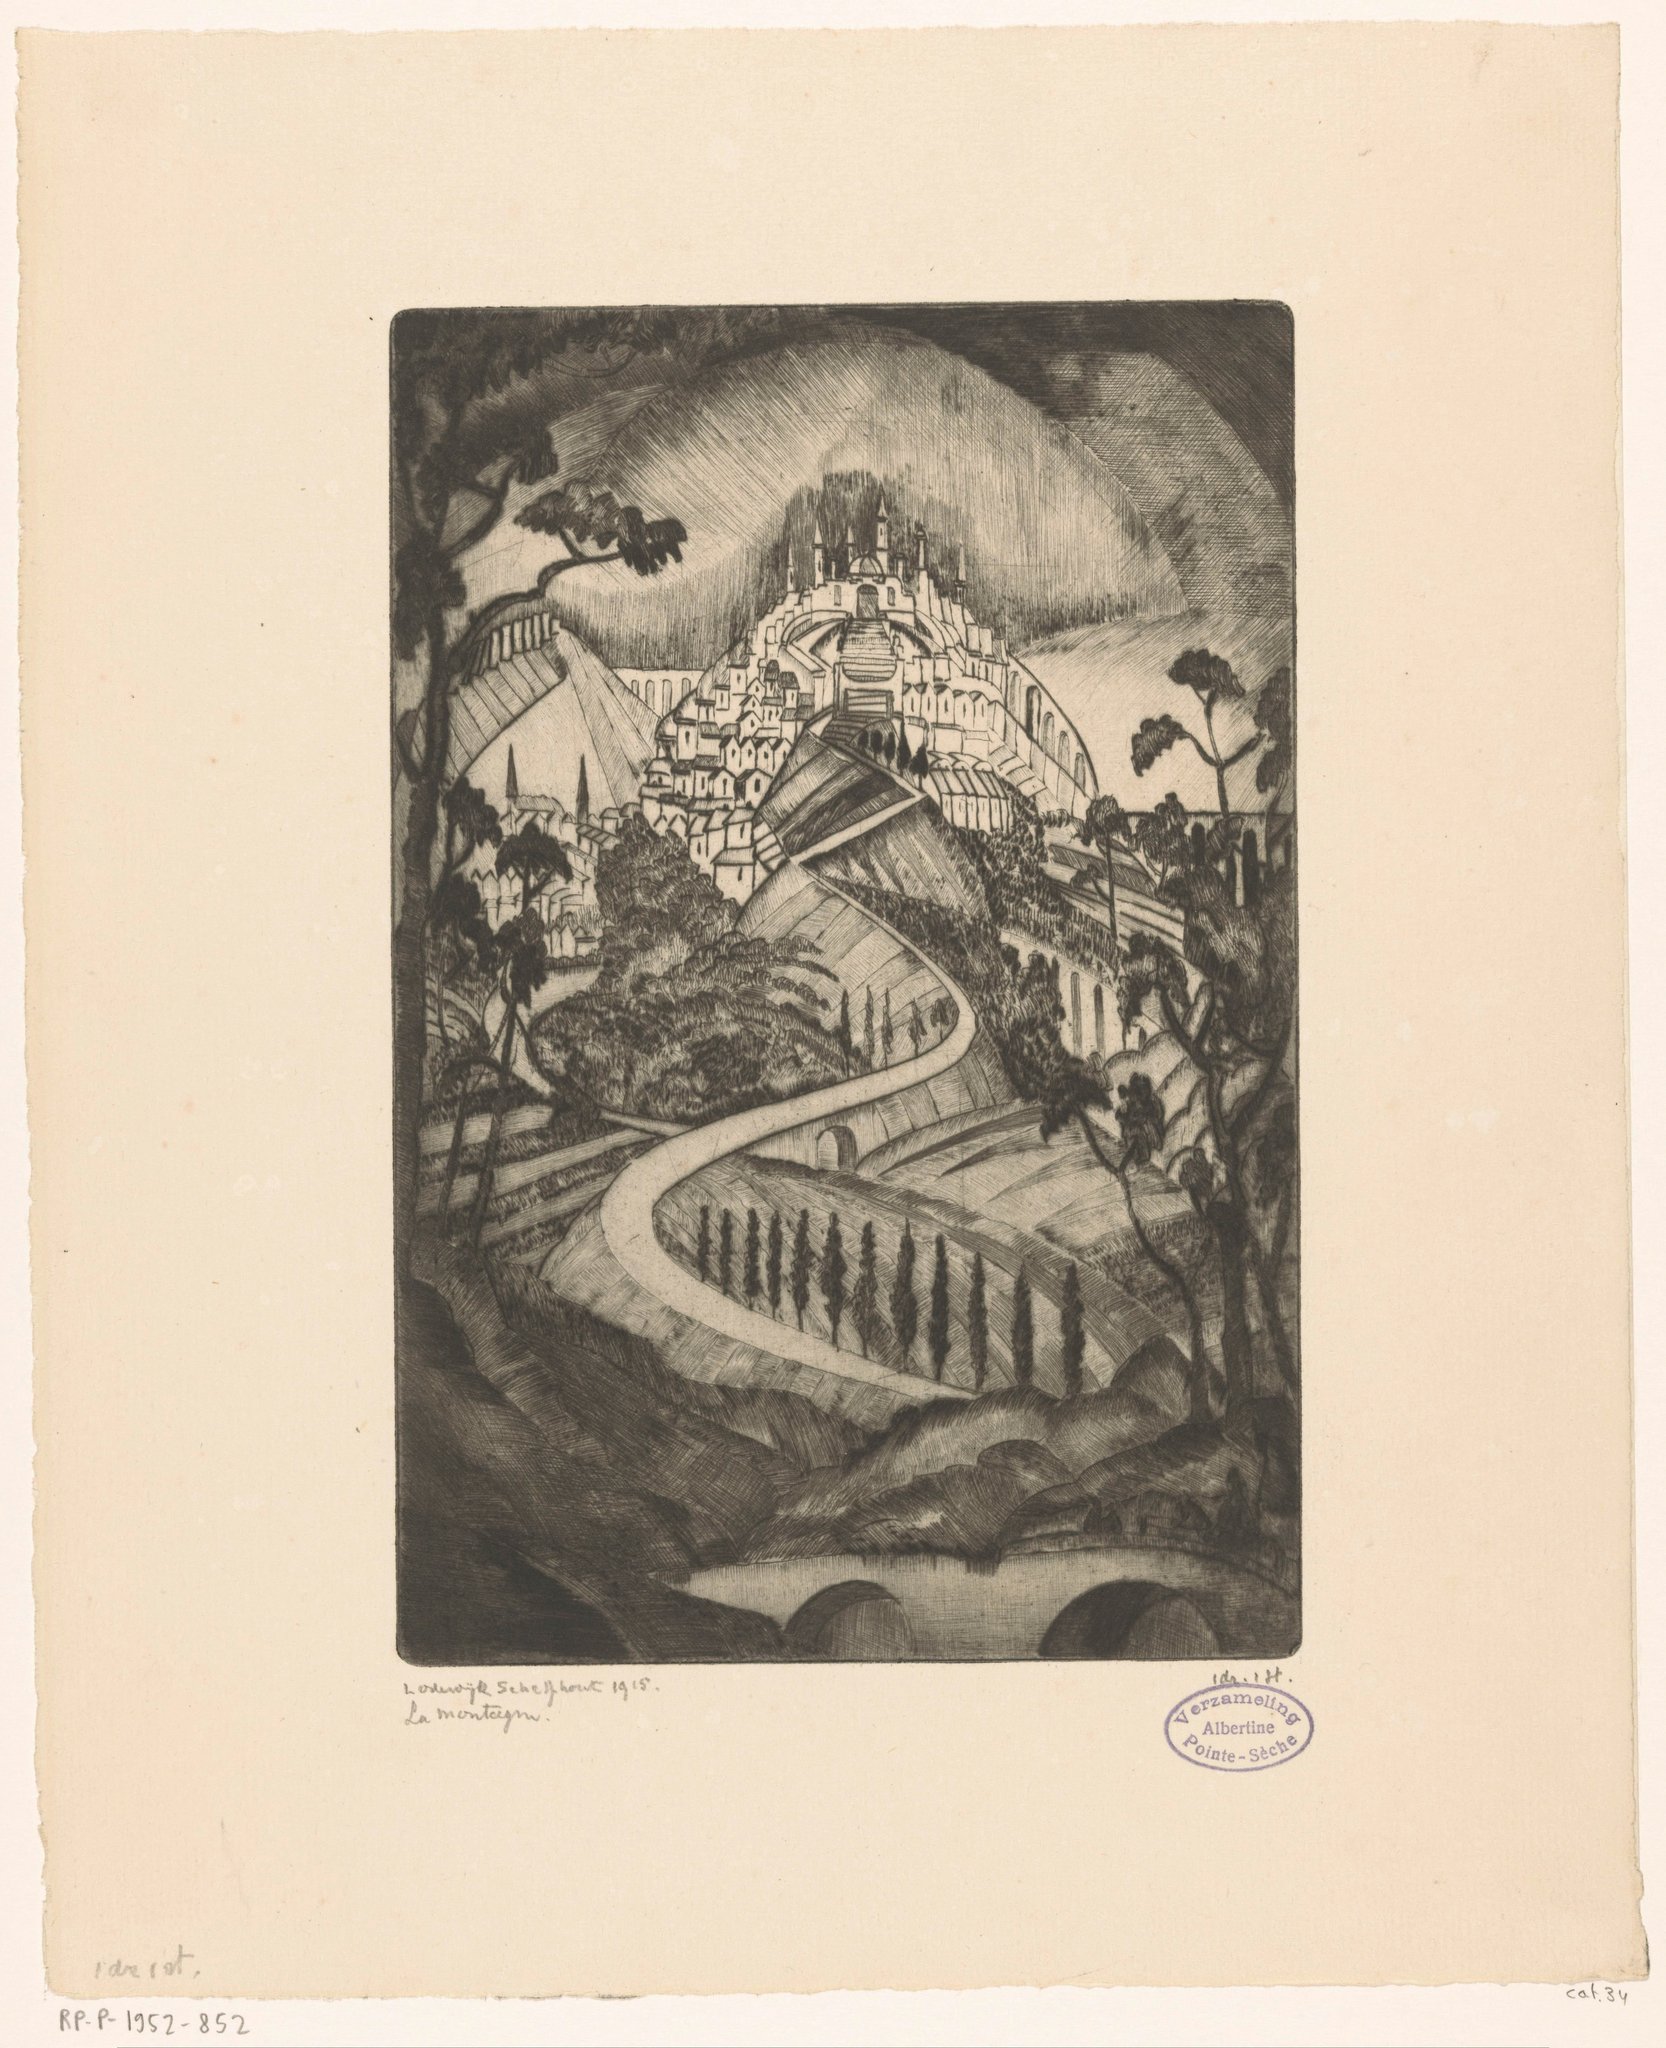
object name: print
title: La Montagne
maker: lodewijk schelfhout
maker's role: draughtsman, print maker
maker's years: 1881-1943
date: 1915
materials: paper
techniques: drypoint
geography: netherlands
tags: prospect of village, silhouette of village, road, path, mountains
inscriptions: collector's mark: Lugt 2228, collector's mark: Lugt 5i, collector's mark: Lugt 2760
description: Huizen en een gebouw met torens op een berg. Op de voorgrond een weg die naar de berg toe kronkelt.